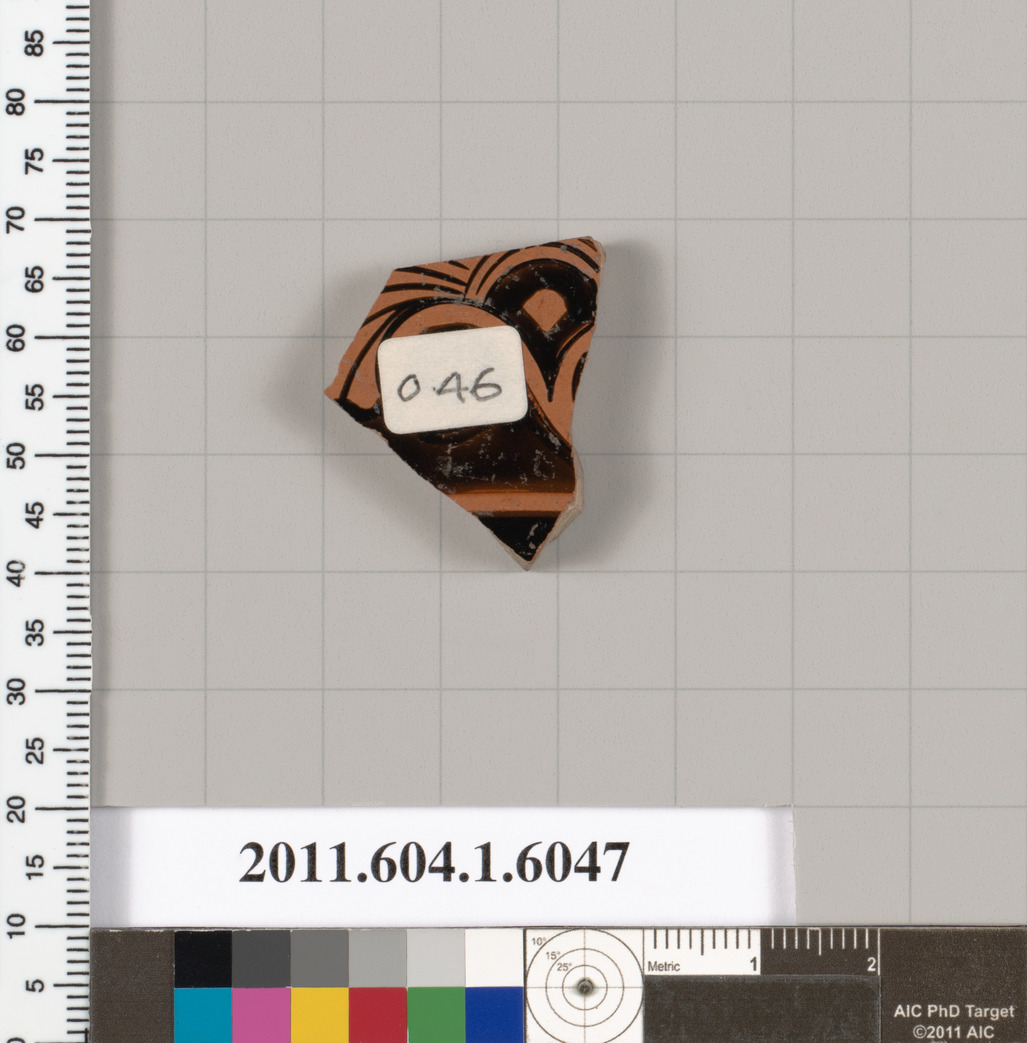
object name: kylix fragment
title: Terracotta fragment of a kylix (drinking cup)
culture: greek, attic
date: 510-500 BCE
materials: terracotta